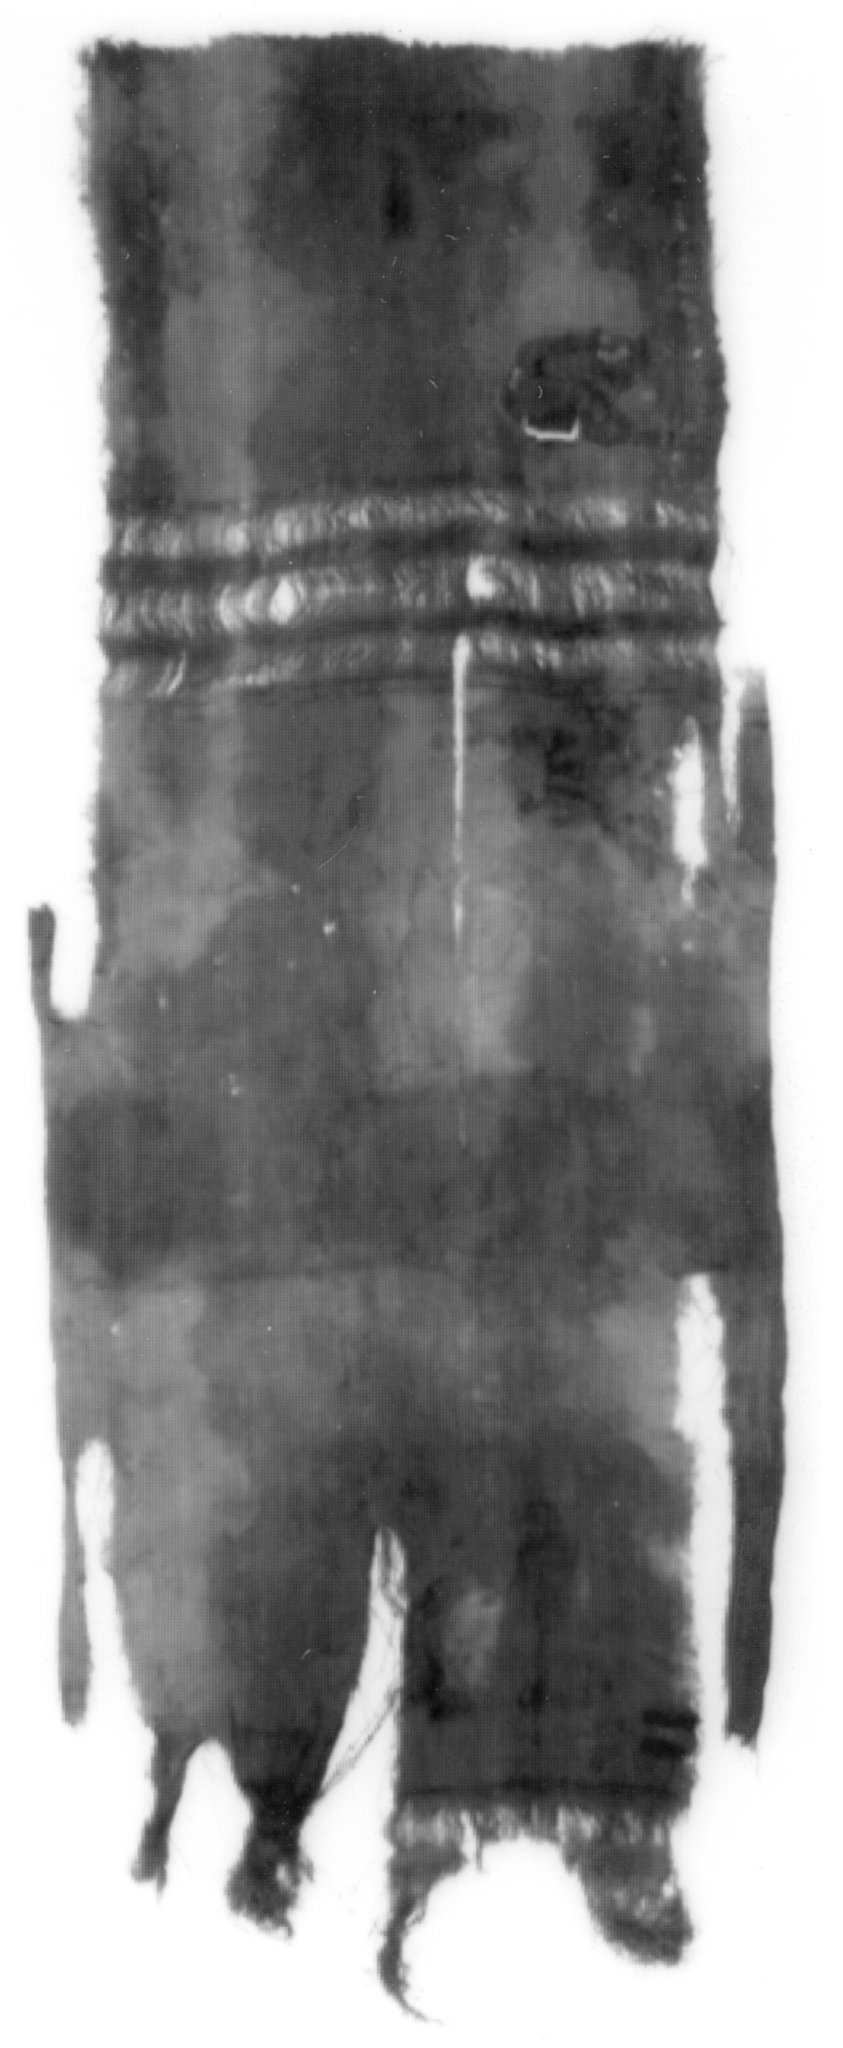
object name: fragment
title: Sheet Fragment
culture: coptic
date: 301-400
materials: linen, wool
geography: egypt